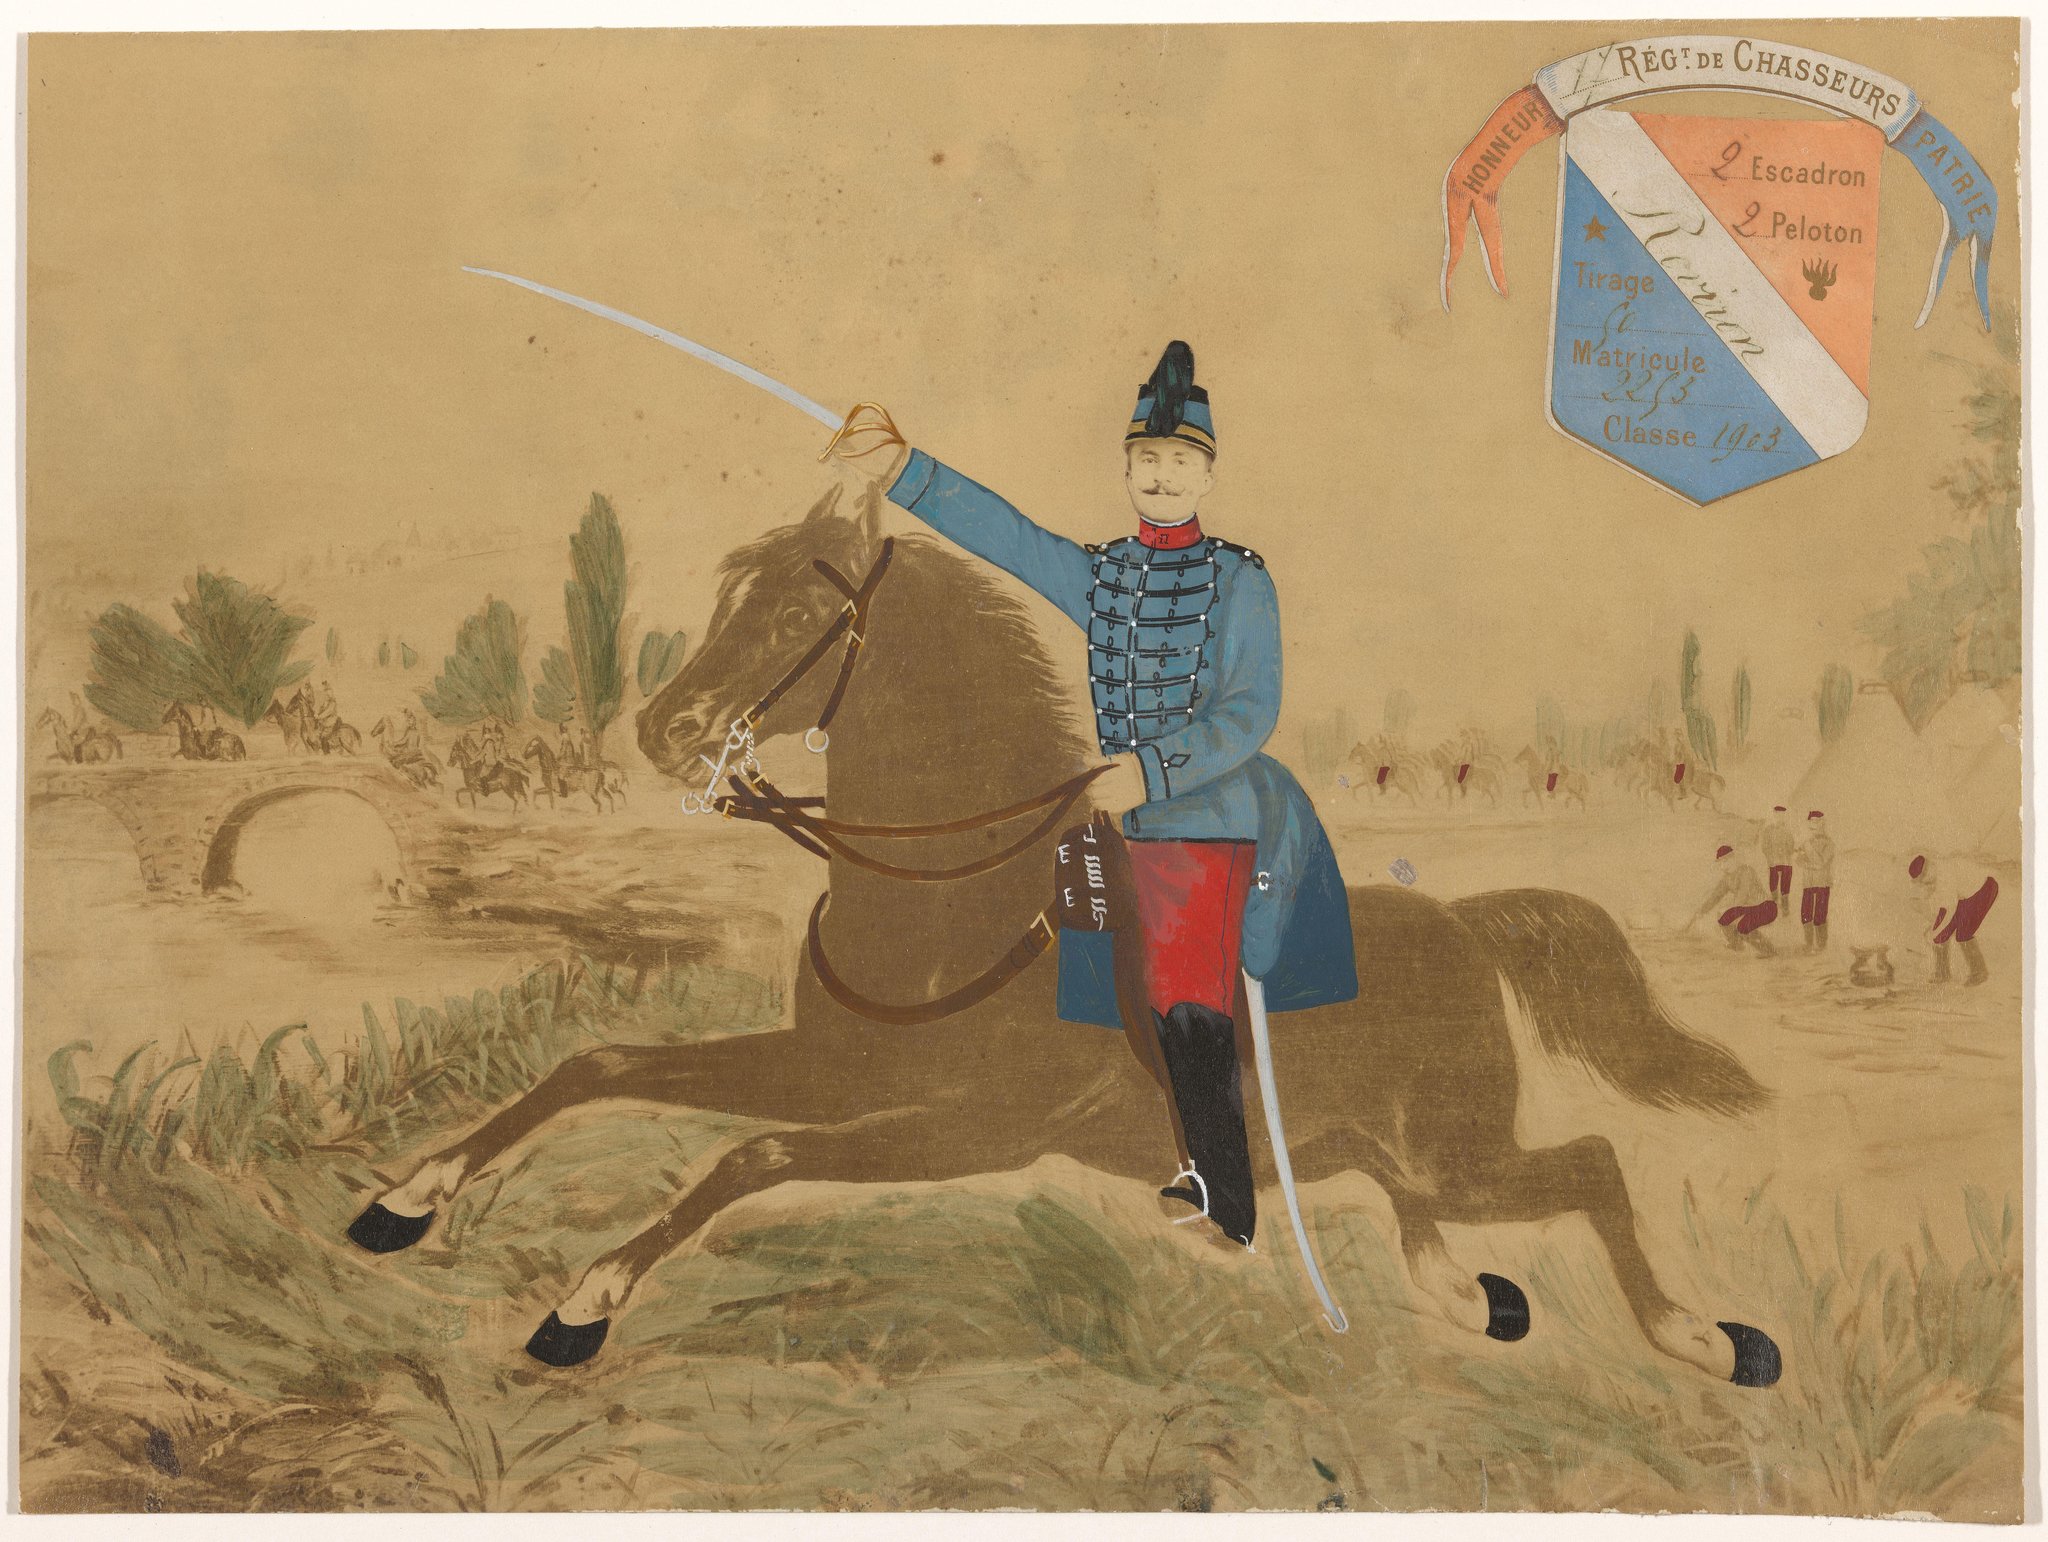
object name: photograph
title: Four Portraits of a Soldier on Horseback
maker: Anonymous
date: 1891-1913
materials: cardboard, paint, photographic support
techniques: albumen print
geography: france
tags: riding a horse, ass, or mule; rider, horseman, warfare; military affairs (+ cavalry, horsemen)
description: Militair van het 17e Régiment de Chasseurs. Onderdeel van 7 portretten van Franse militairen uit verschillende regimenten en jaren.